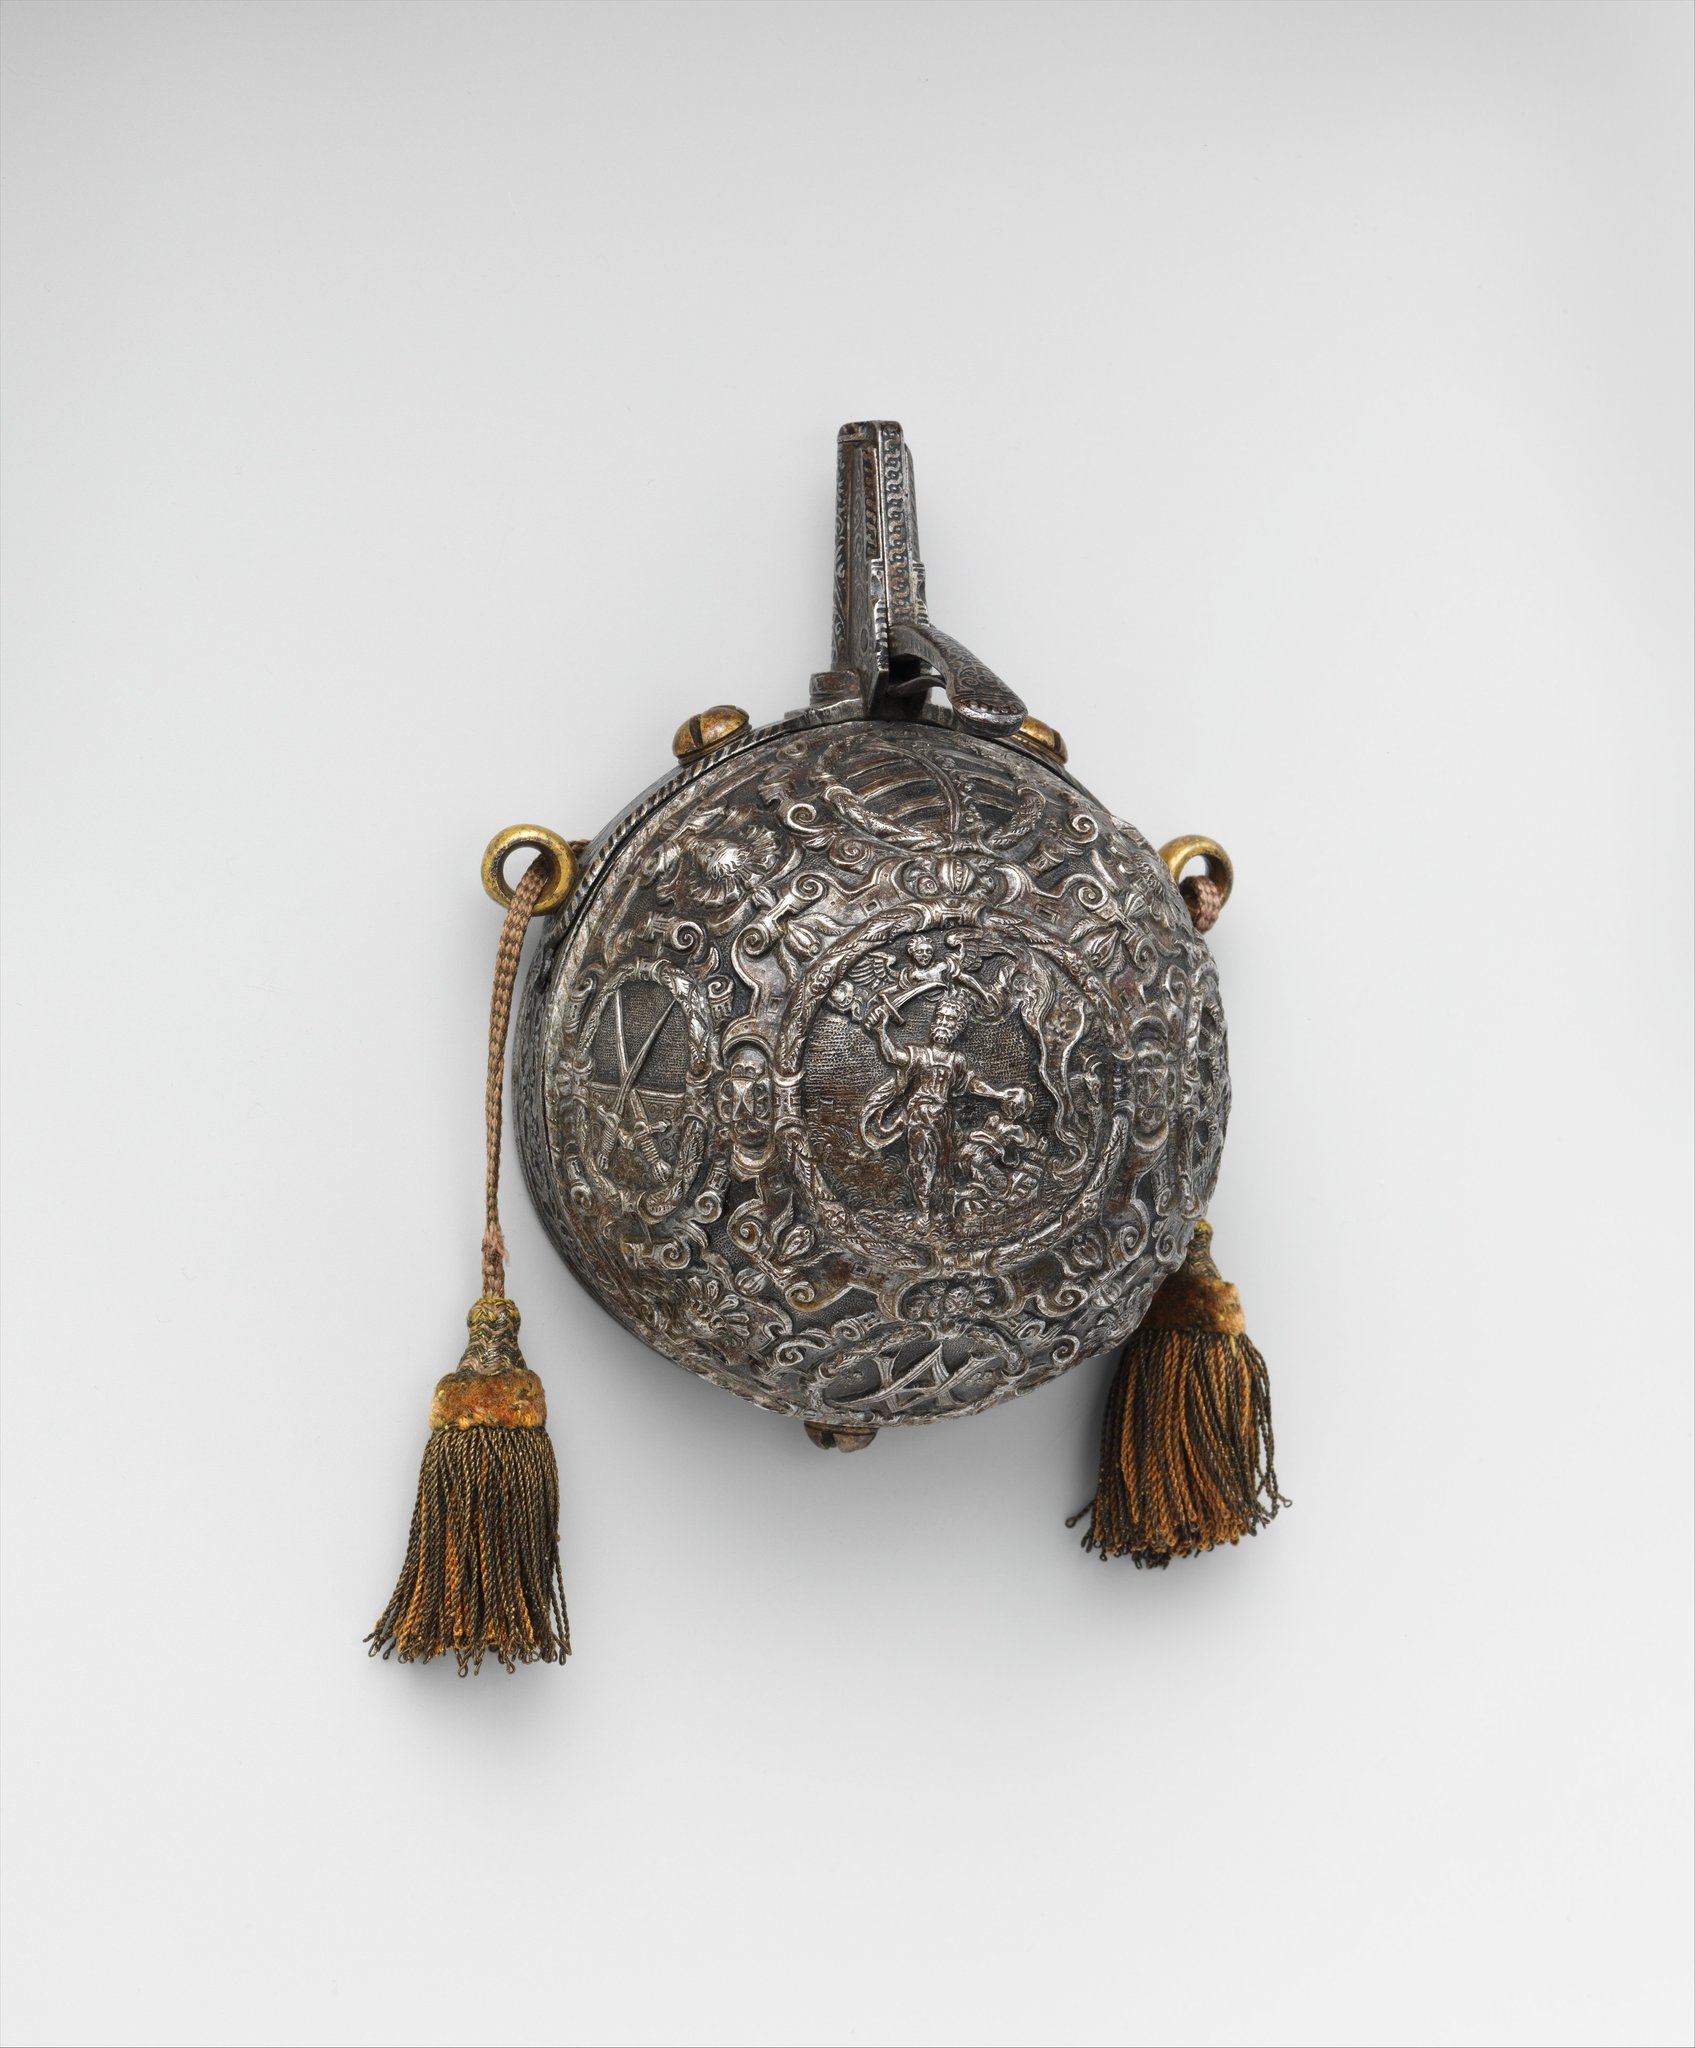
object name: priming flask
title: Priming Flask Bearing the Monograms and Arms of the Prince-Elector August I of Saxony (reigned 1553–86) and Anna of Denmark (reigned 1553–85)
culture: german, saxony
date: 1575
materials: gold, iron, silk, silver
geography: germany